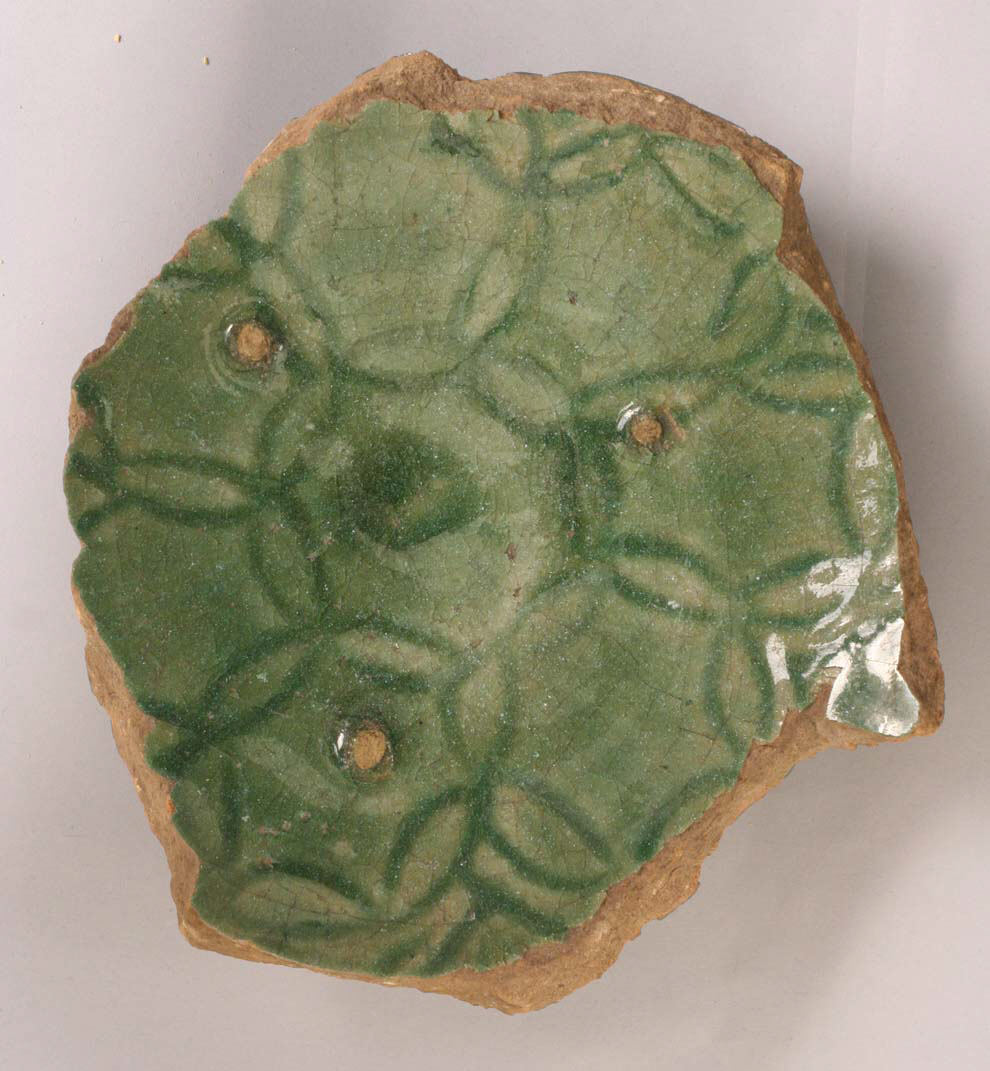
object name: ceramic fragment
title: Fragment of a Dish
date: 1201-1400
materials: earthenware, glaze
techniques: incising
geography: egypt